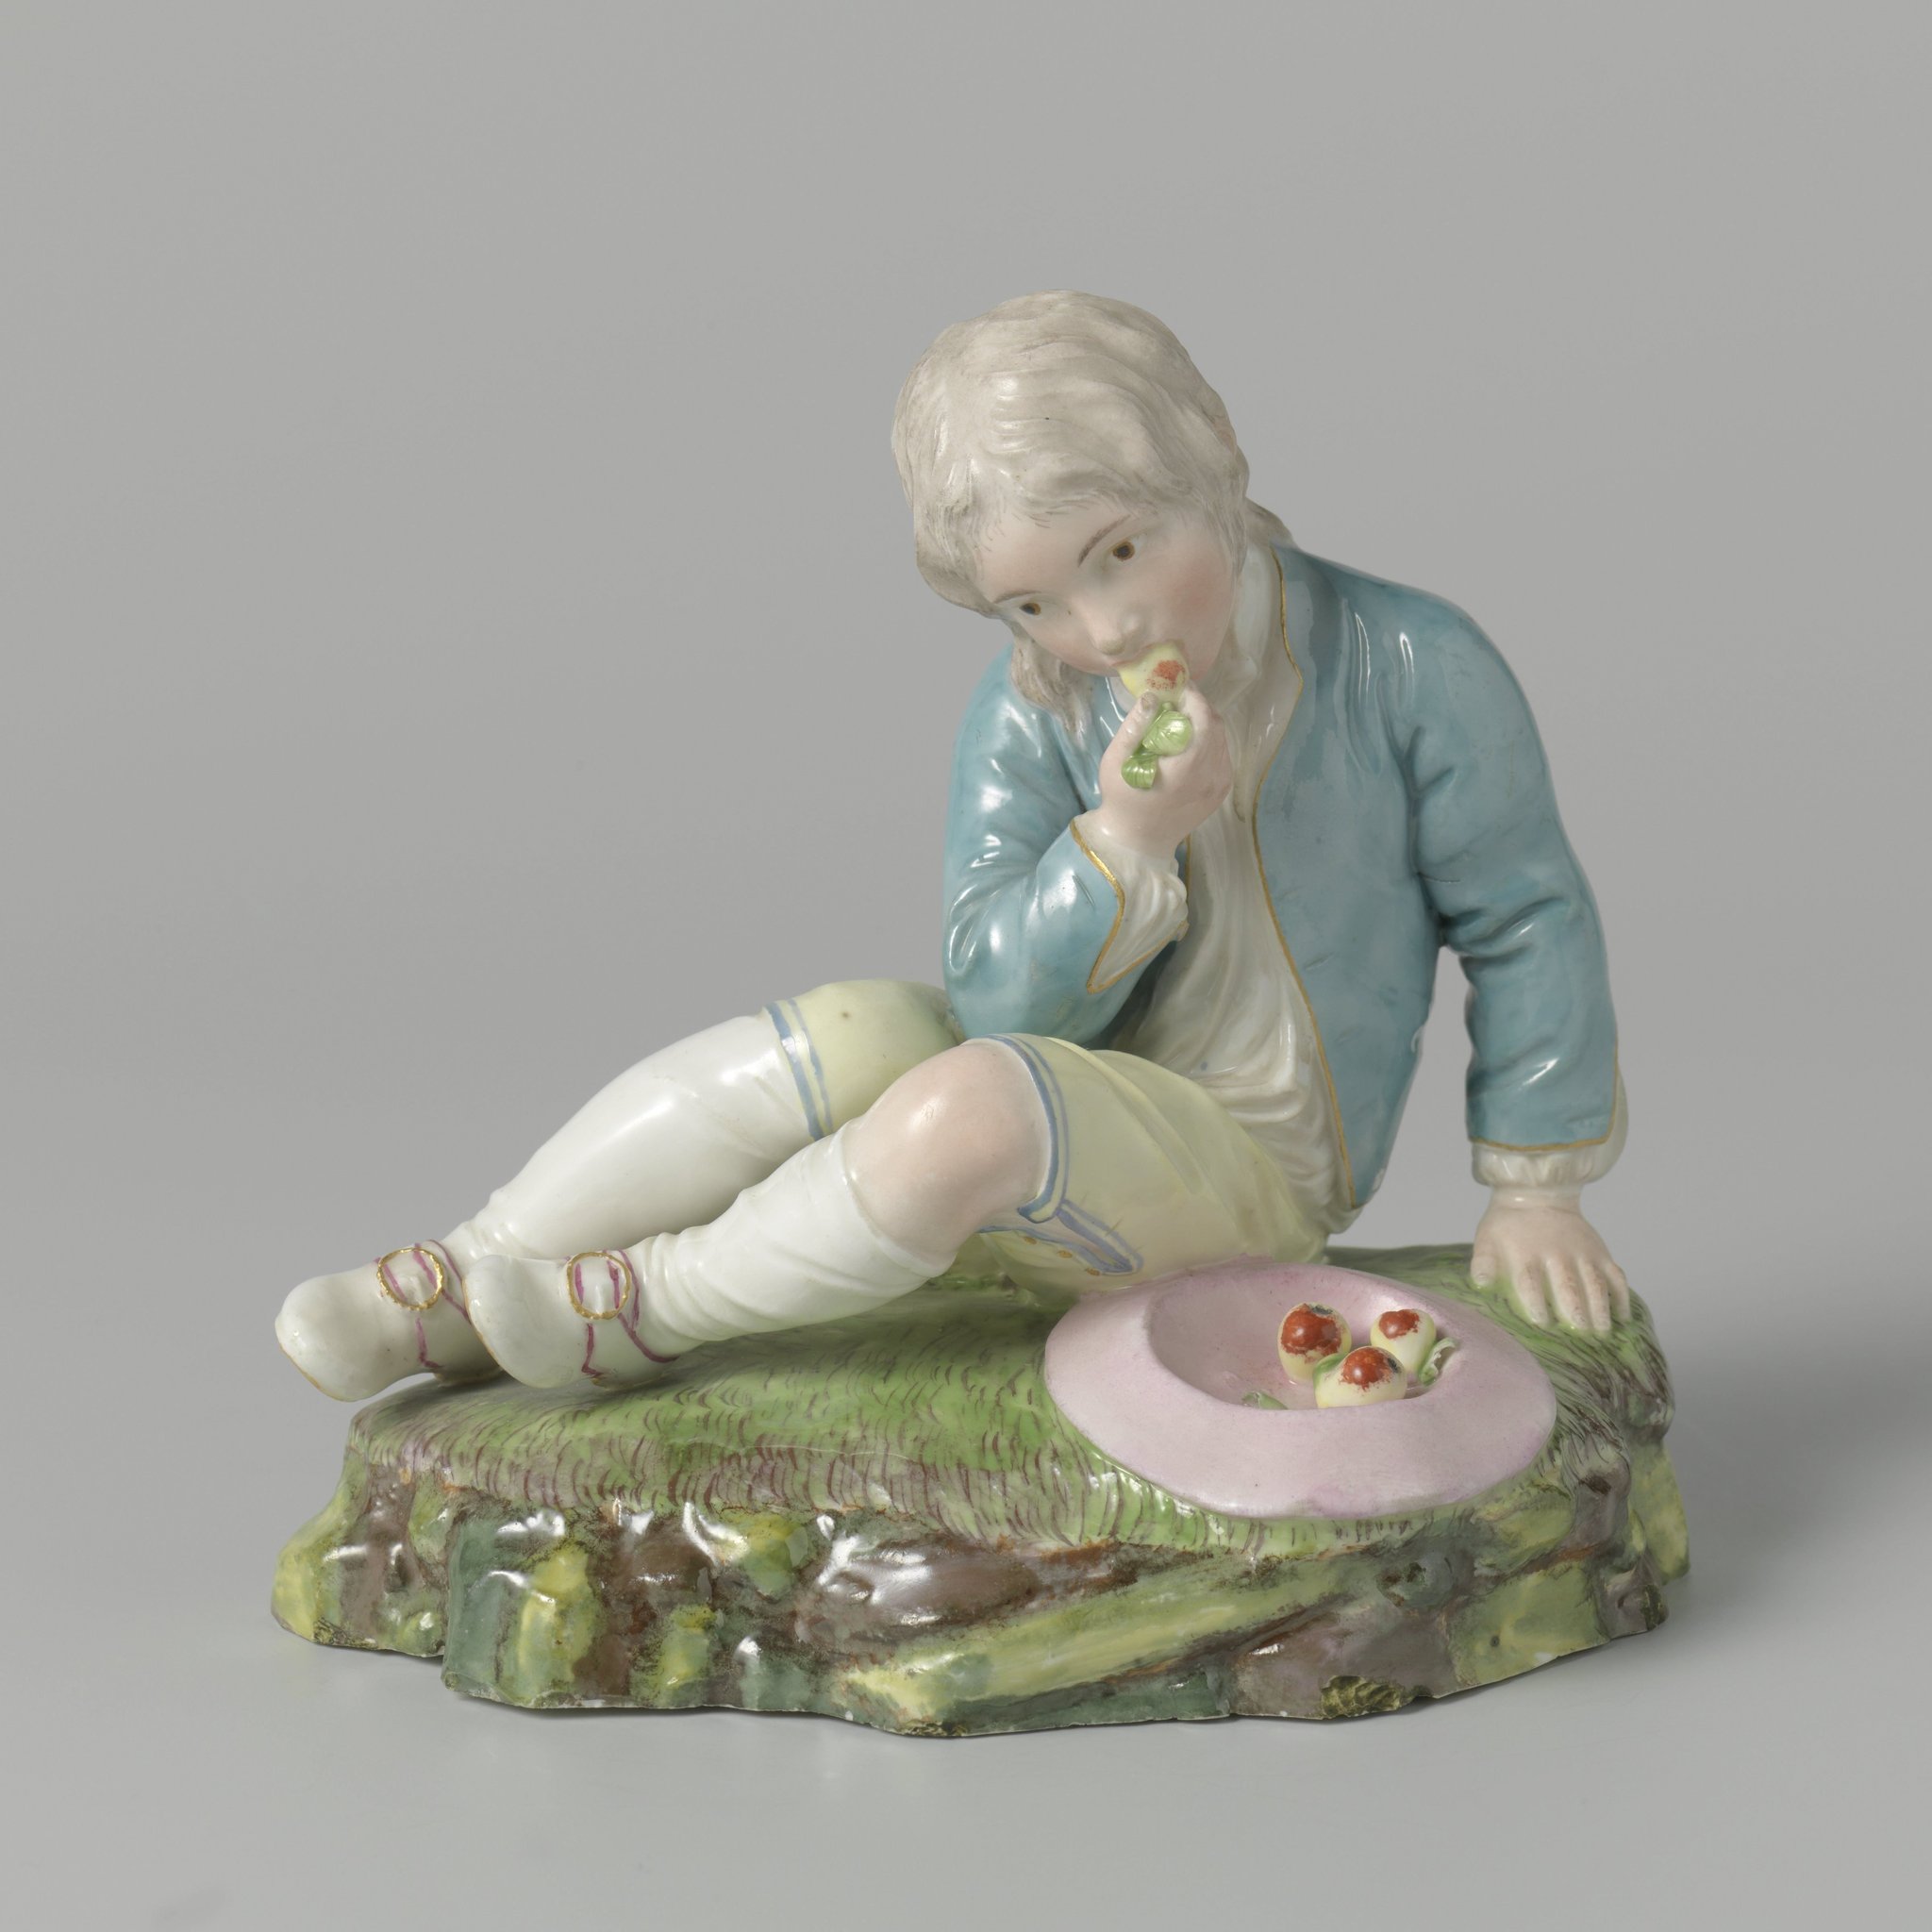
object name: figure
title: Figure of a seated boy with fruit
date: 1770-1780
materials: glaze, gold, paint, porcelain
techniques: firing, forming, gilding, vitrification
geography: höchst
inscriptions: mark: ‘wiel/ No. 179’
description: Figure. Porcelain. Höchst, c. 1770 - 1780. Given by C.P. van Eeghen, 1908.